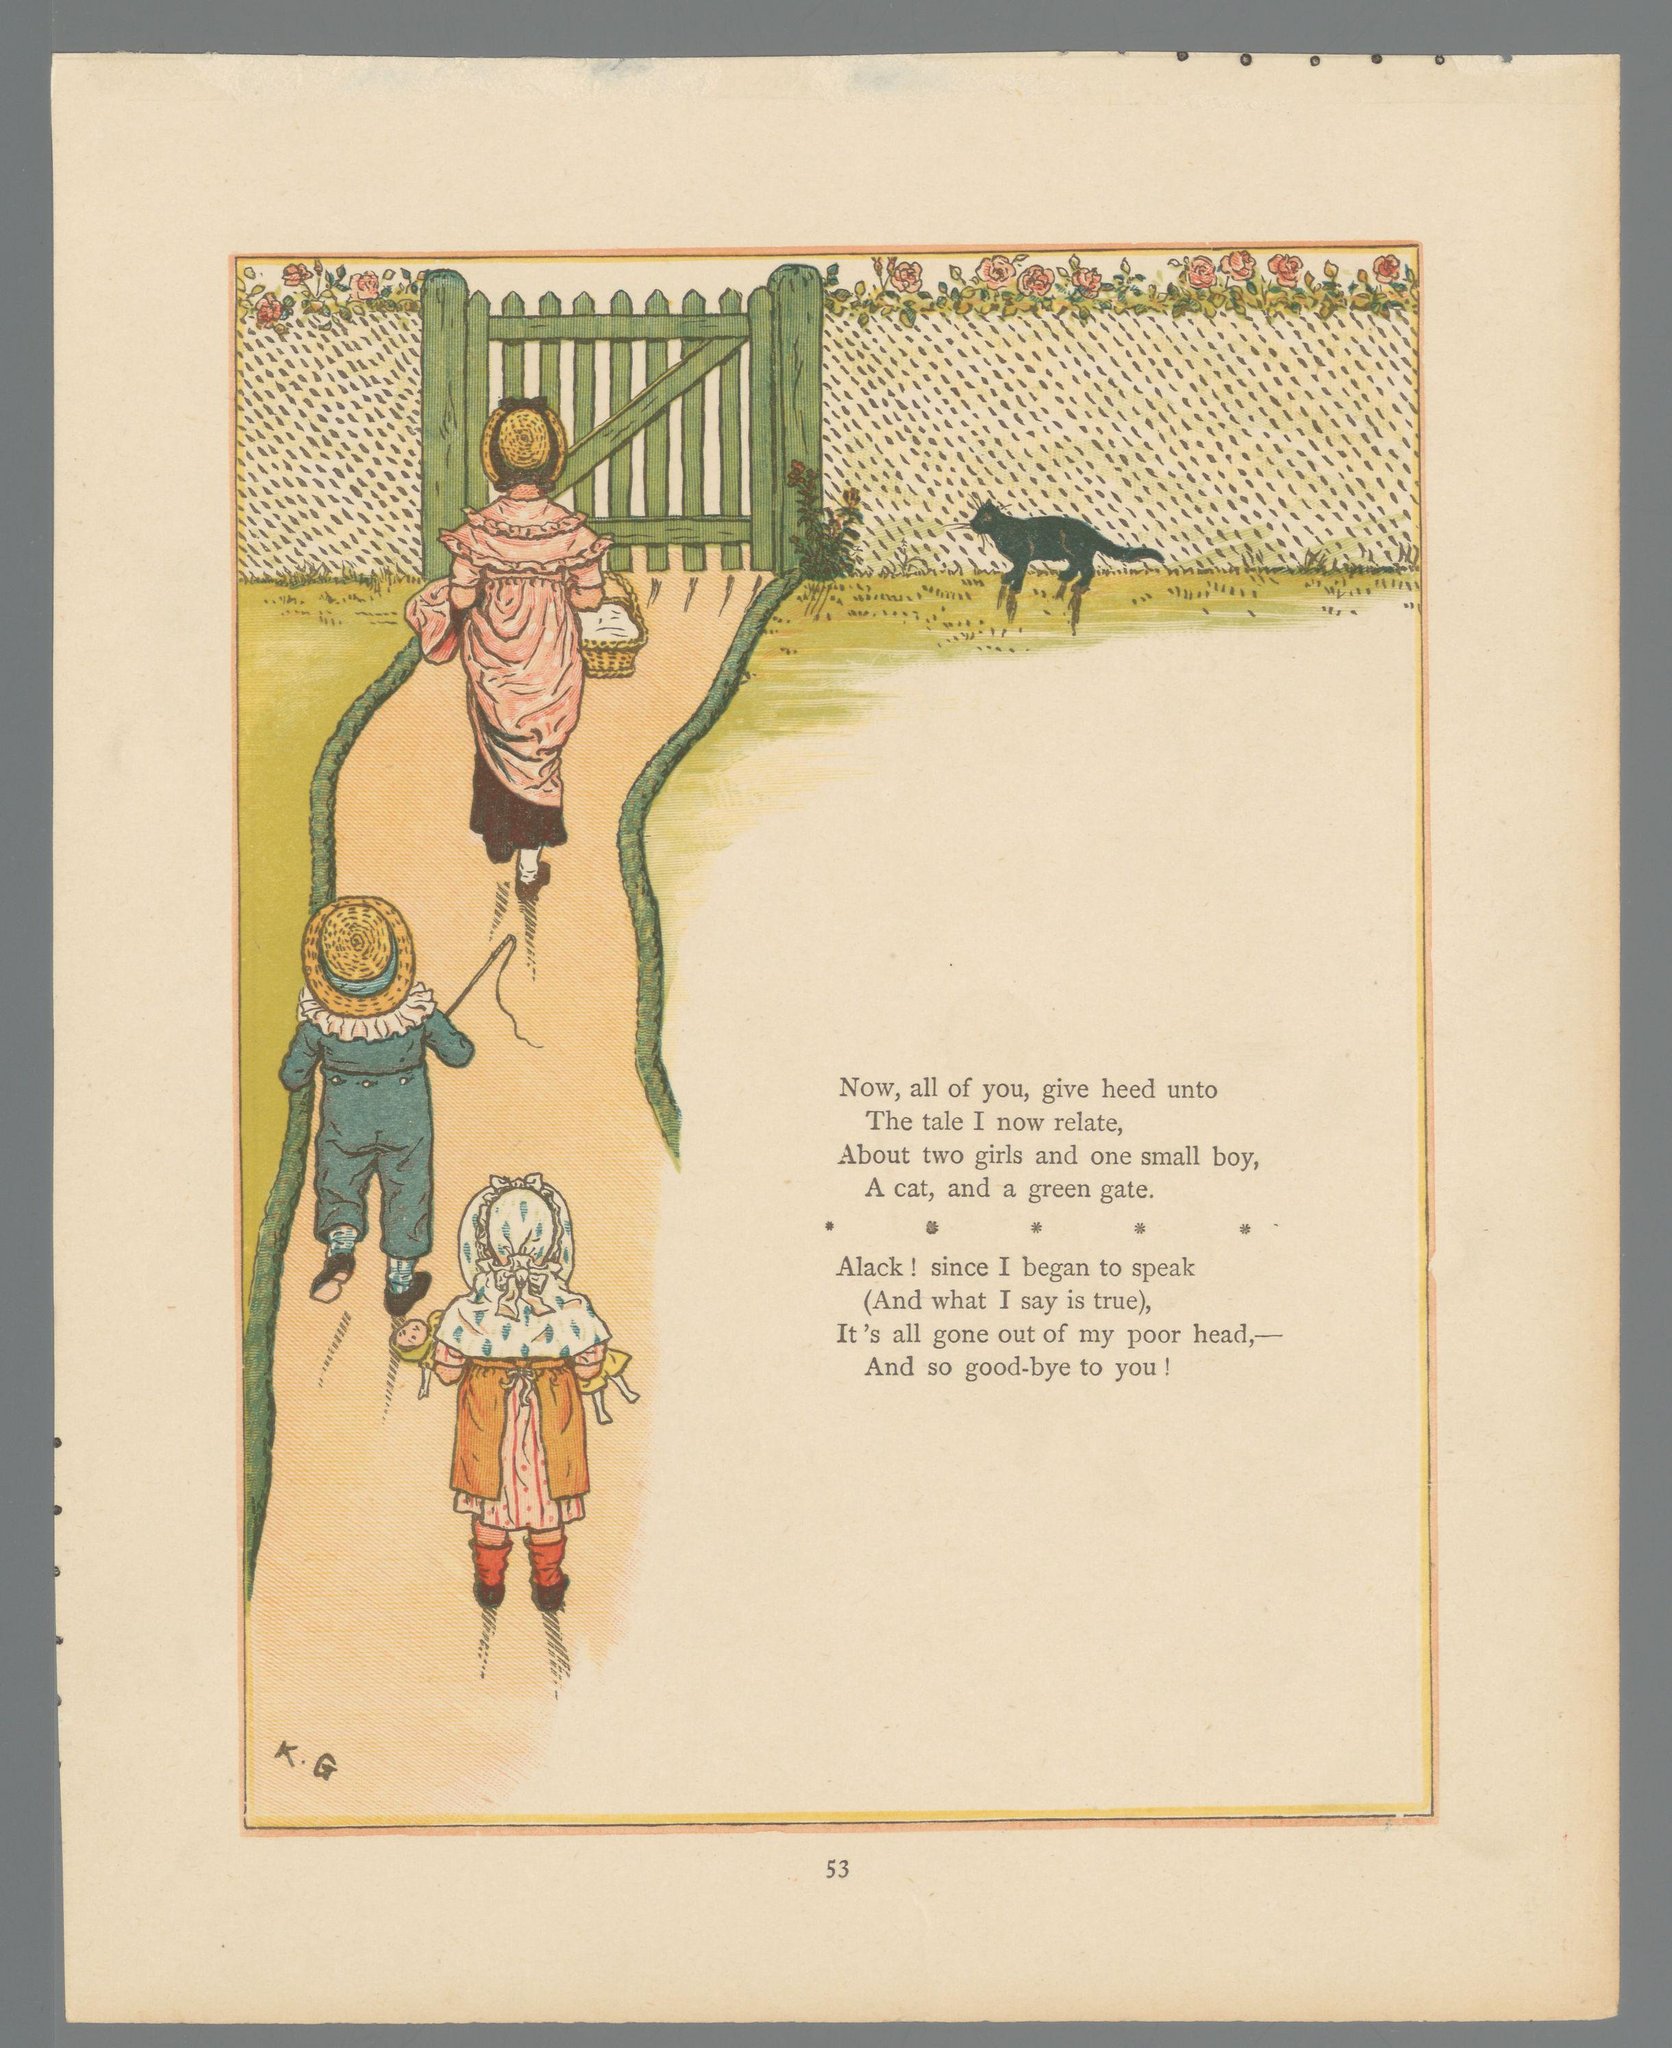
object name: book illustration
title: Drie kinderen op een pad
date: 1878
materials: paper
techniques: wood engraving, letterpress printing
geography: london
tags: cat, road, path, child (+ three persons)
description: Prent uit: Greenaway, Kate. Under the window, pictures & rhymes for children. Londen: George Routledge & Sons, 1878, p. 53.